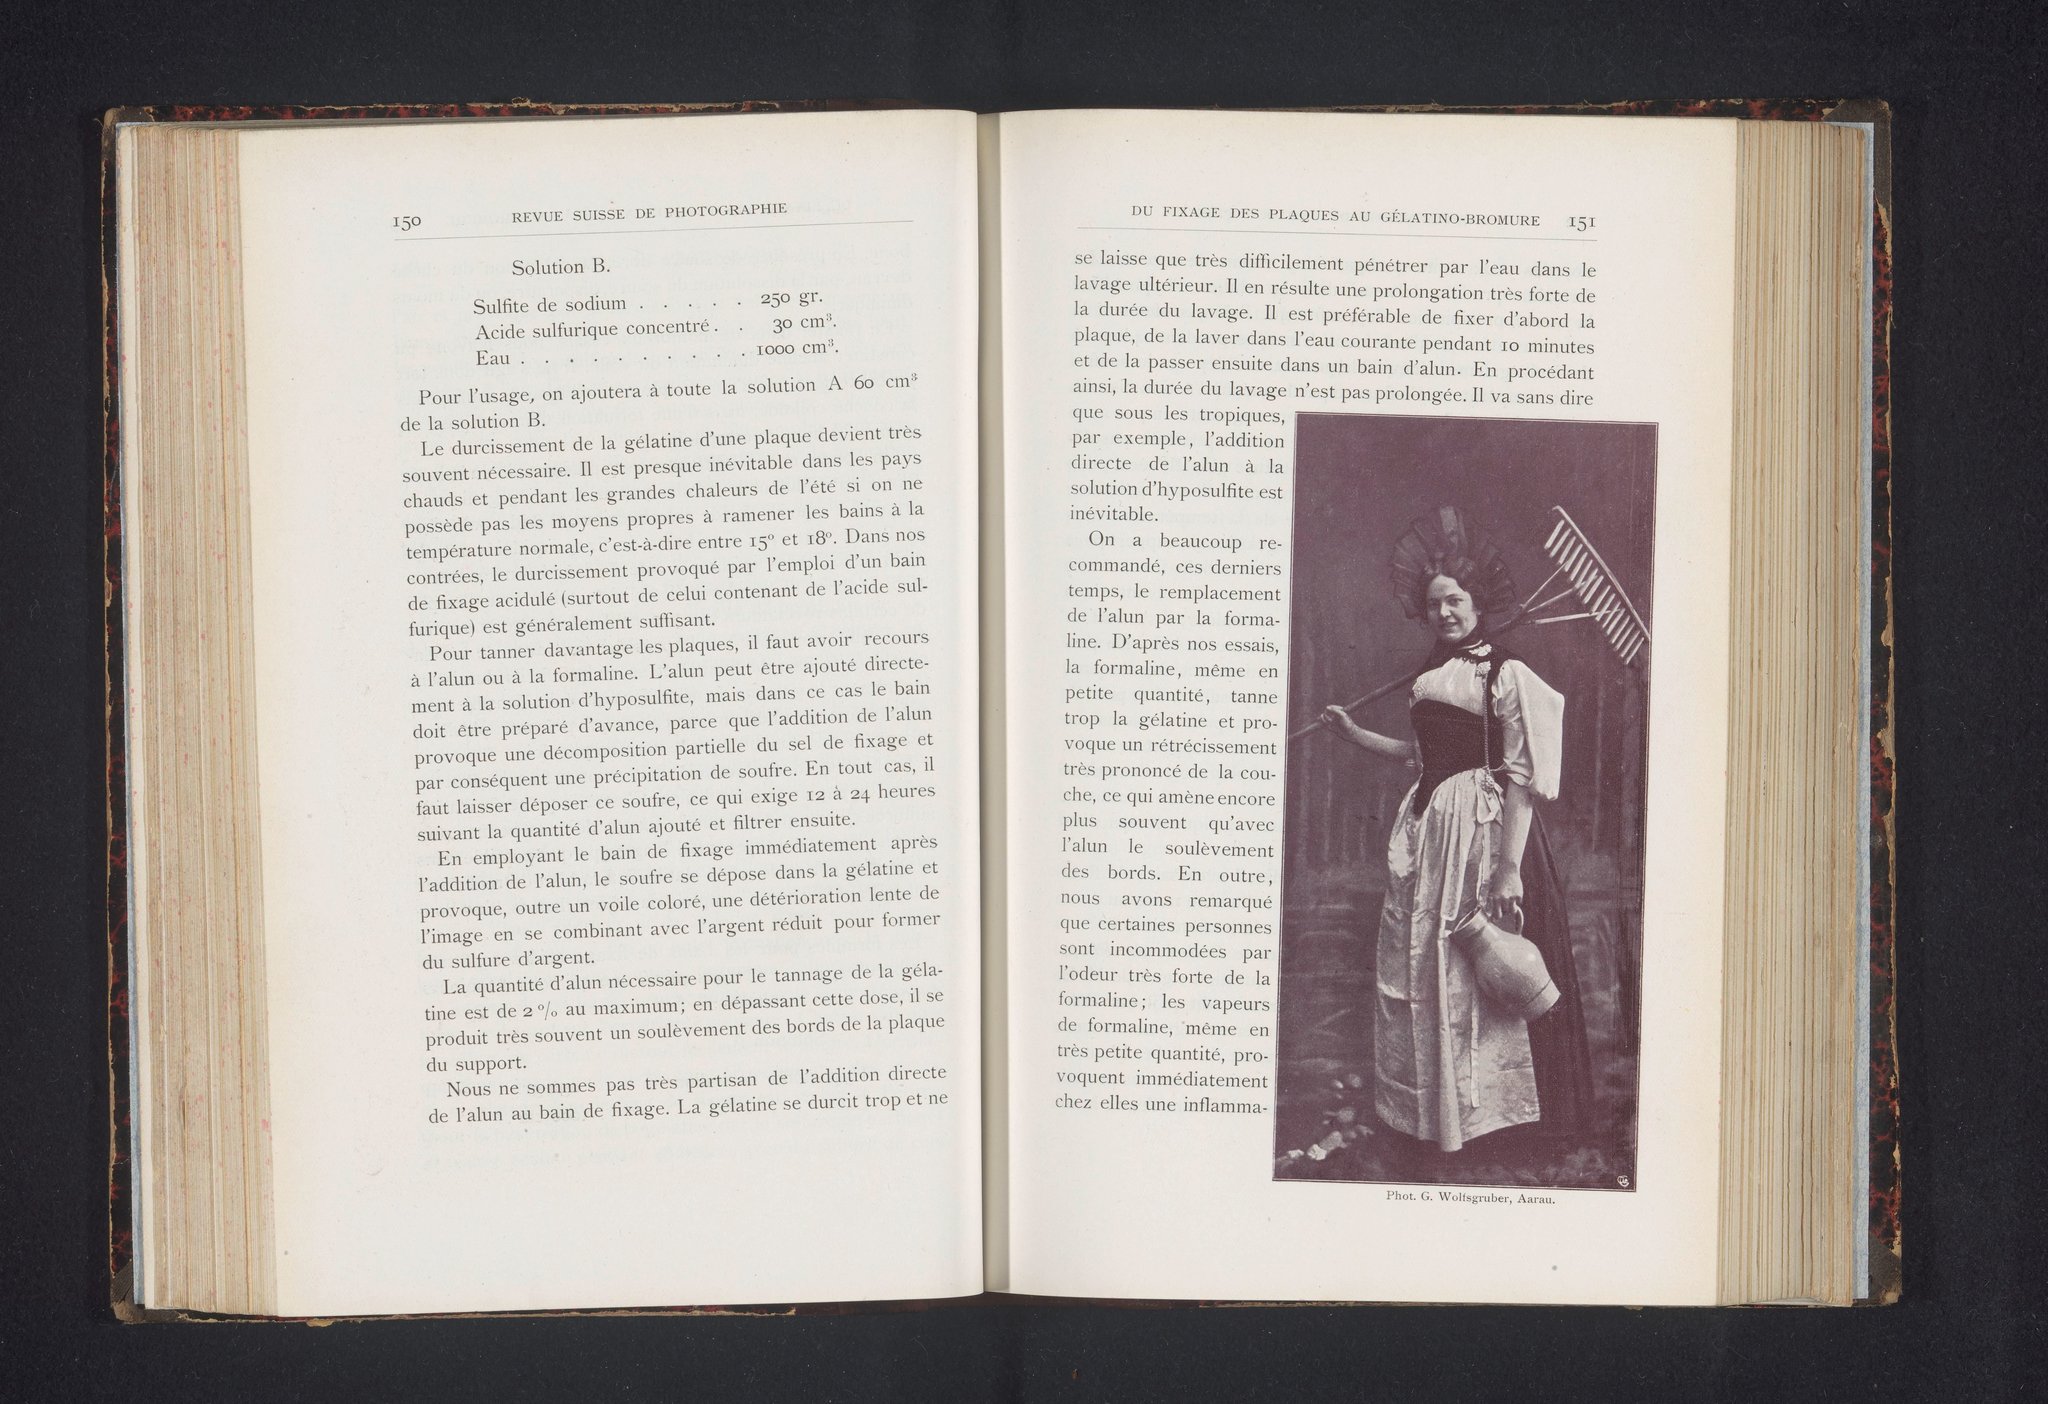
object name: photomechanical print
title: Portret van een onbekende vrouw met een hark en een kan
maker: gottfried wolfsgruber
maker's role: fotograaf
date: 1897-1902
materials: paper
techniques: autotype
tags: historical persons - bb - woman, container of ceramics: jar, jug, pot, vase, agricultural implements: rake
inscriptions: monogram: ‘C. Cie’